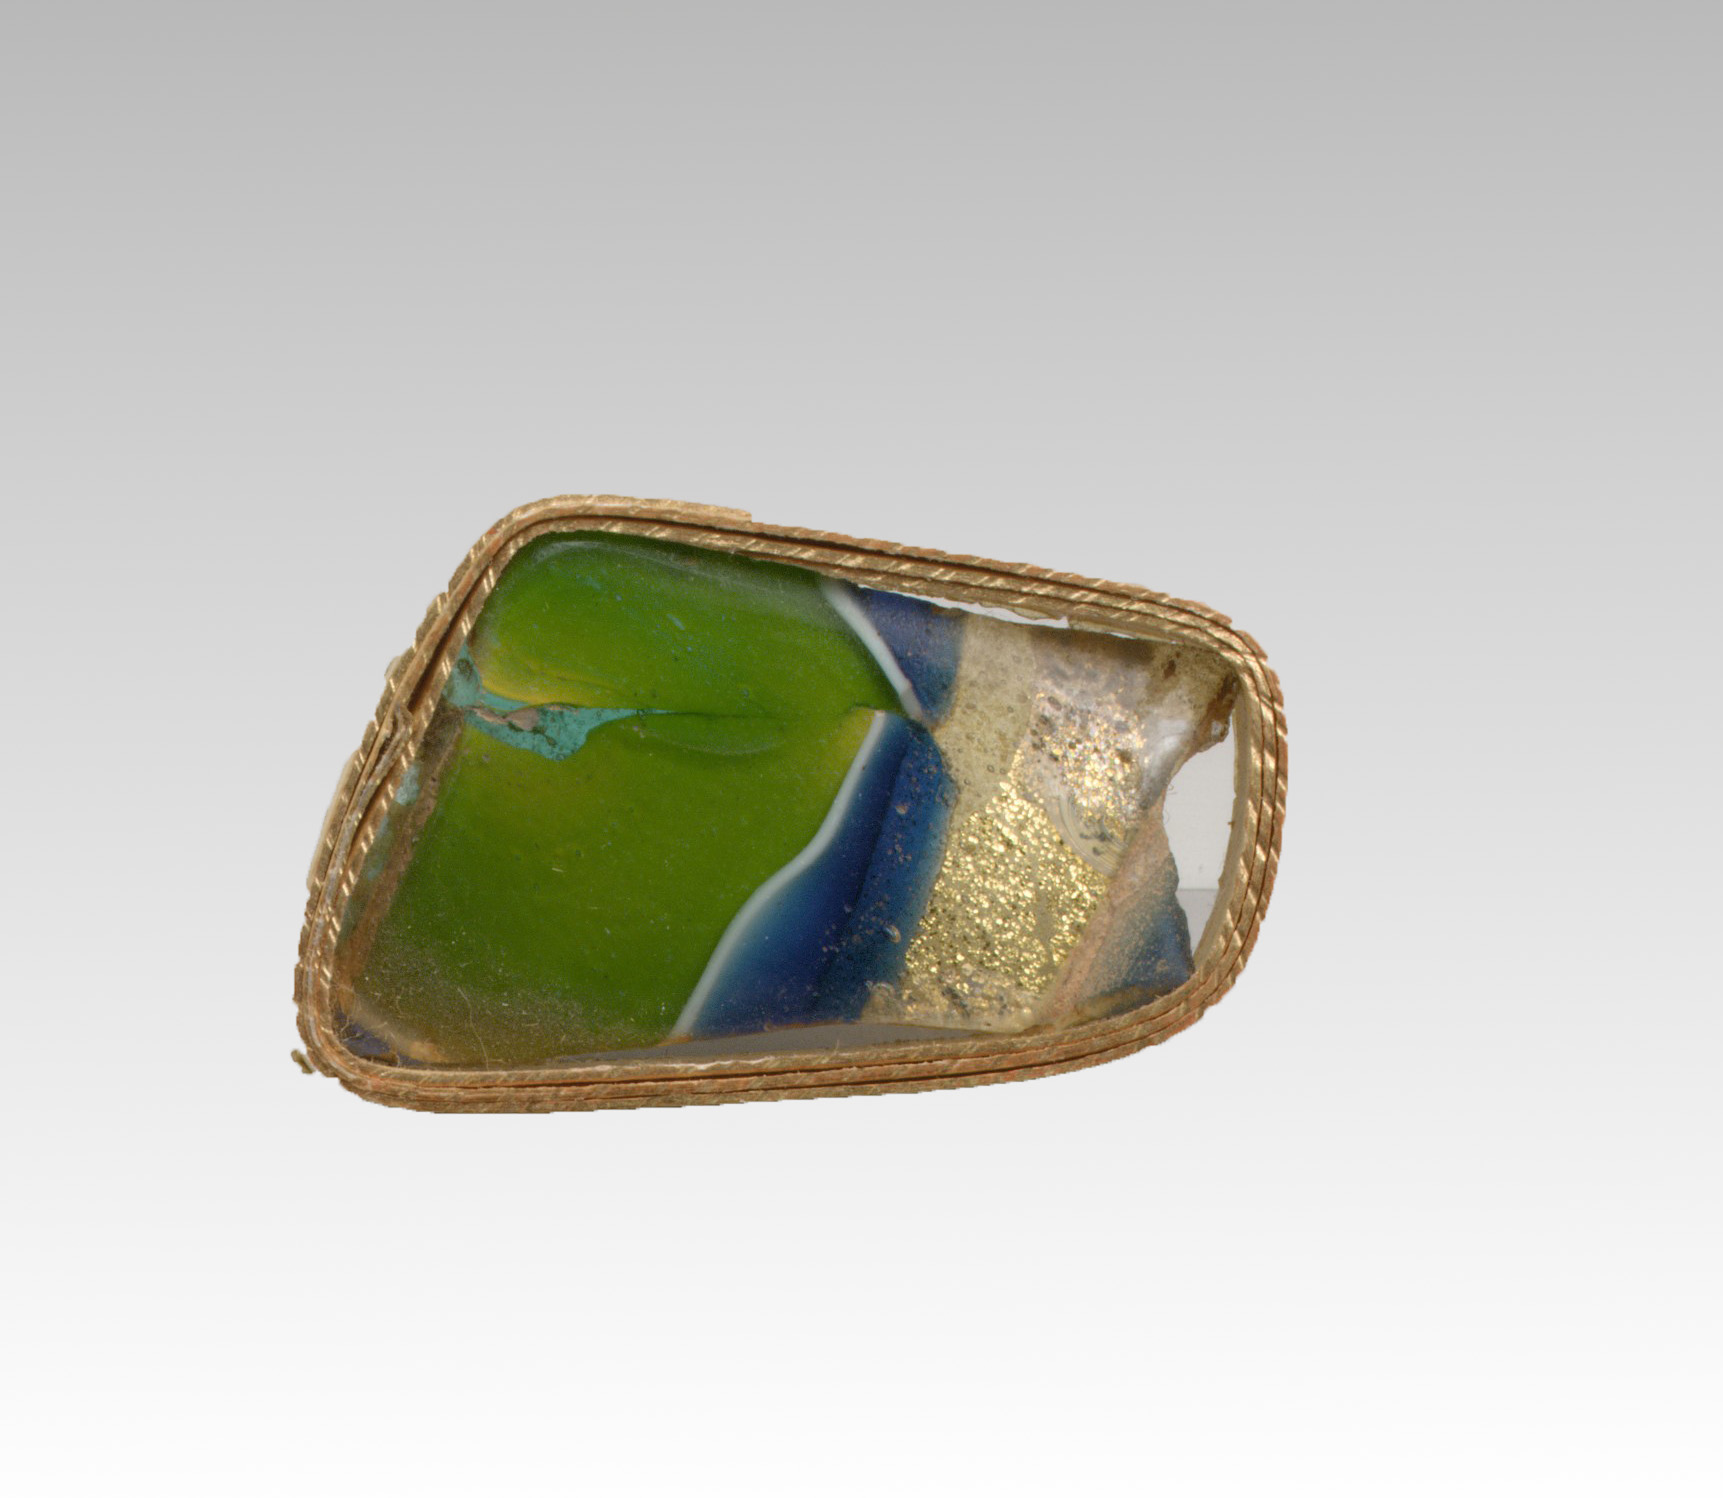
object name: fragment, gold band mosaic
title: Glass gold-band mosaic bowl fragment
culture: roman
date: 34 BCE-33 CE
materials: glass